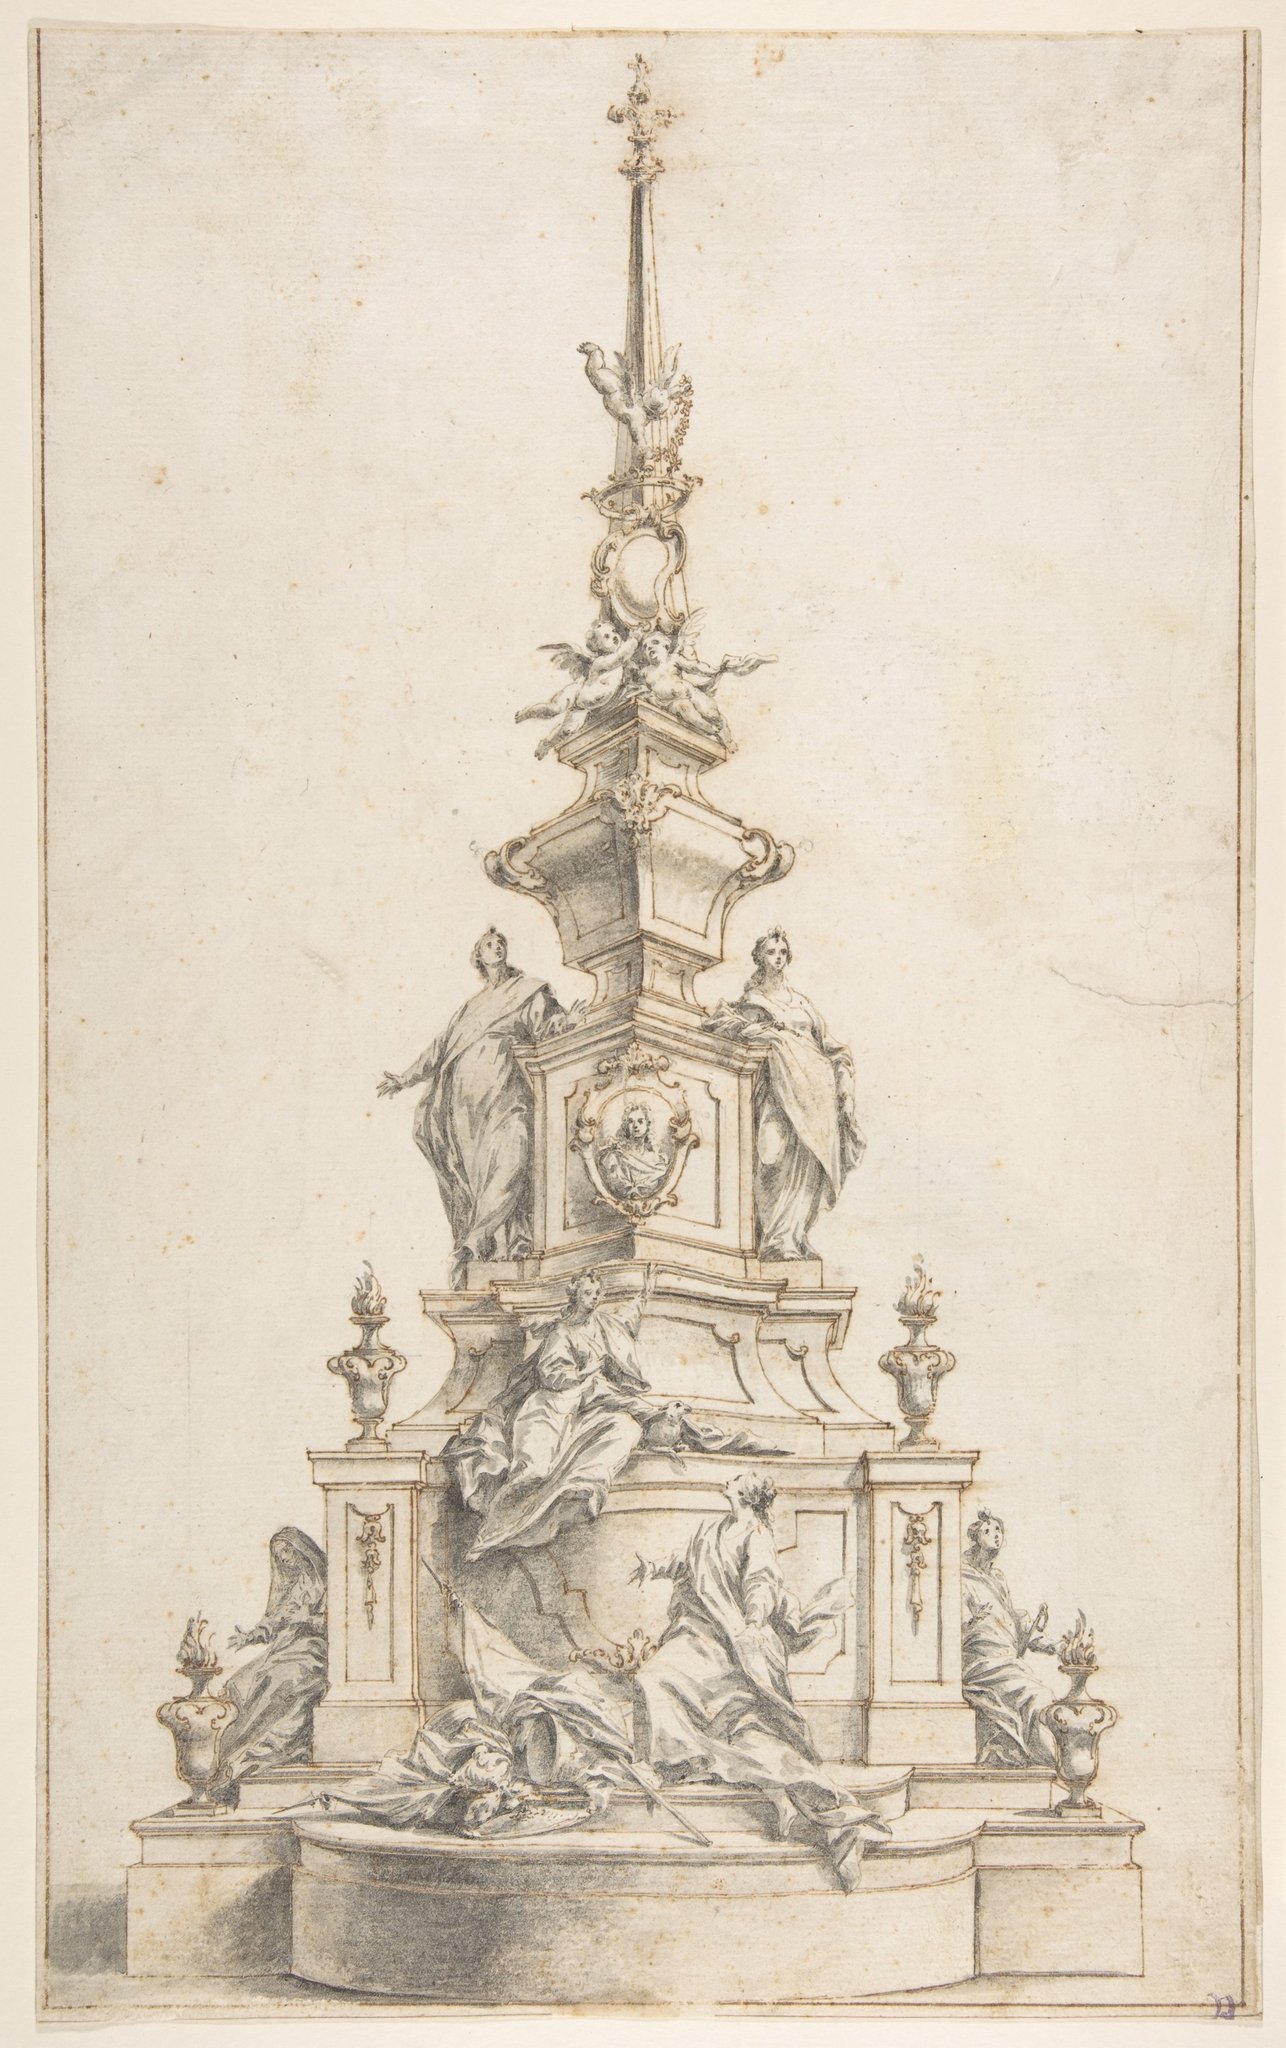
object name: drawing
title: Design for a Funerary Monument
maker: ignaz günther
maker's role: artist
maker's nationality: german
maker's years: 1725-1775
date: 1710-1740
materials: ink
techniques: incising, pen, transfer, wash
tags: monuments,women,cross